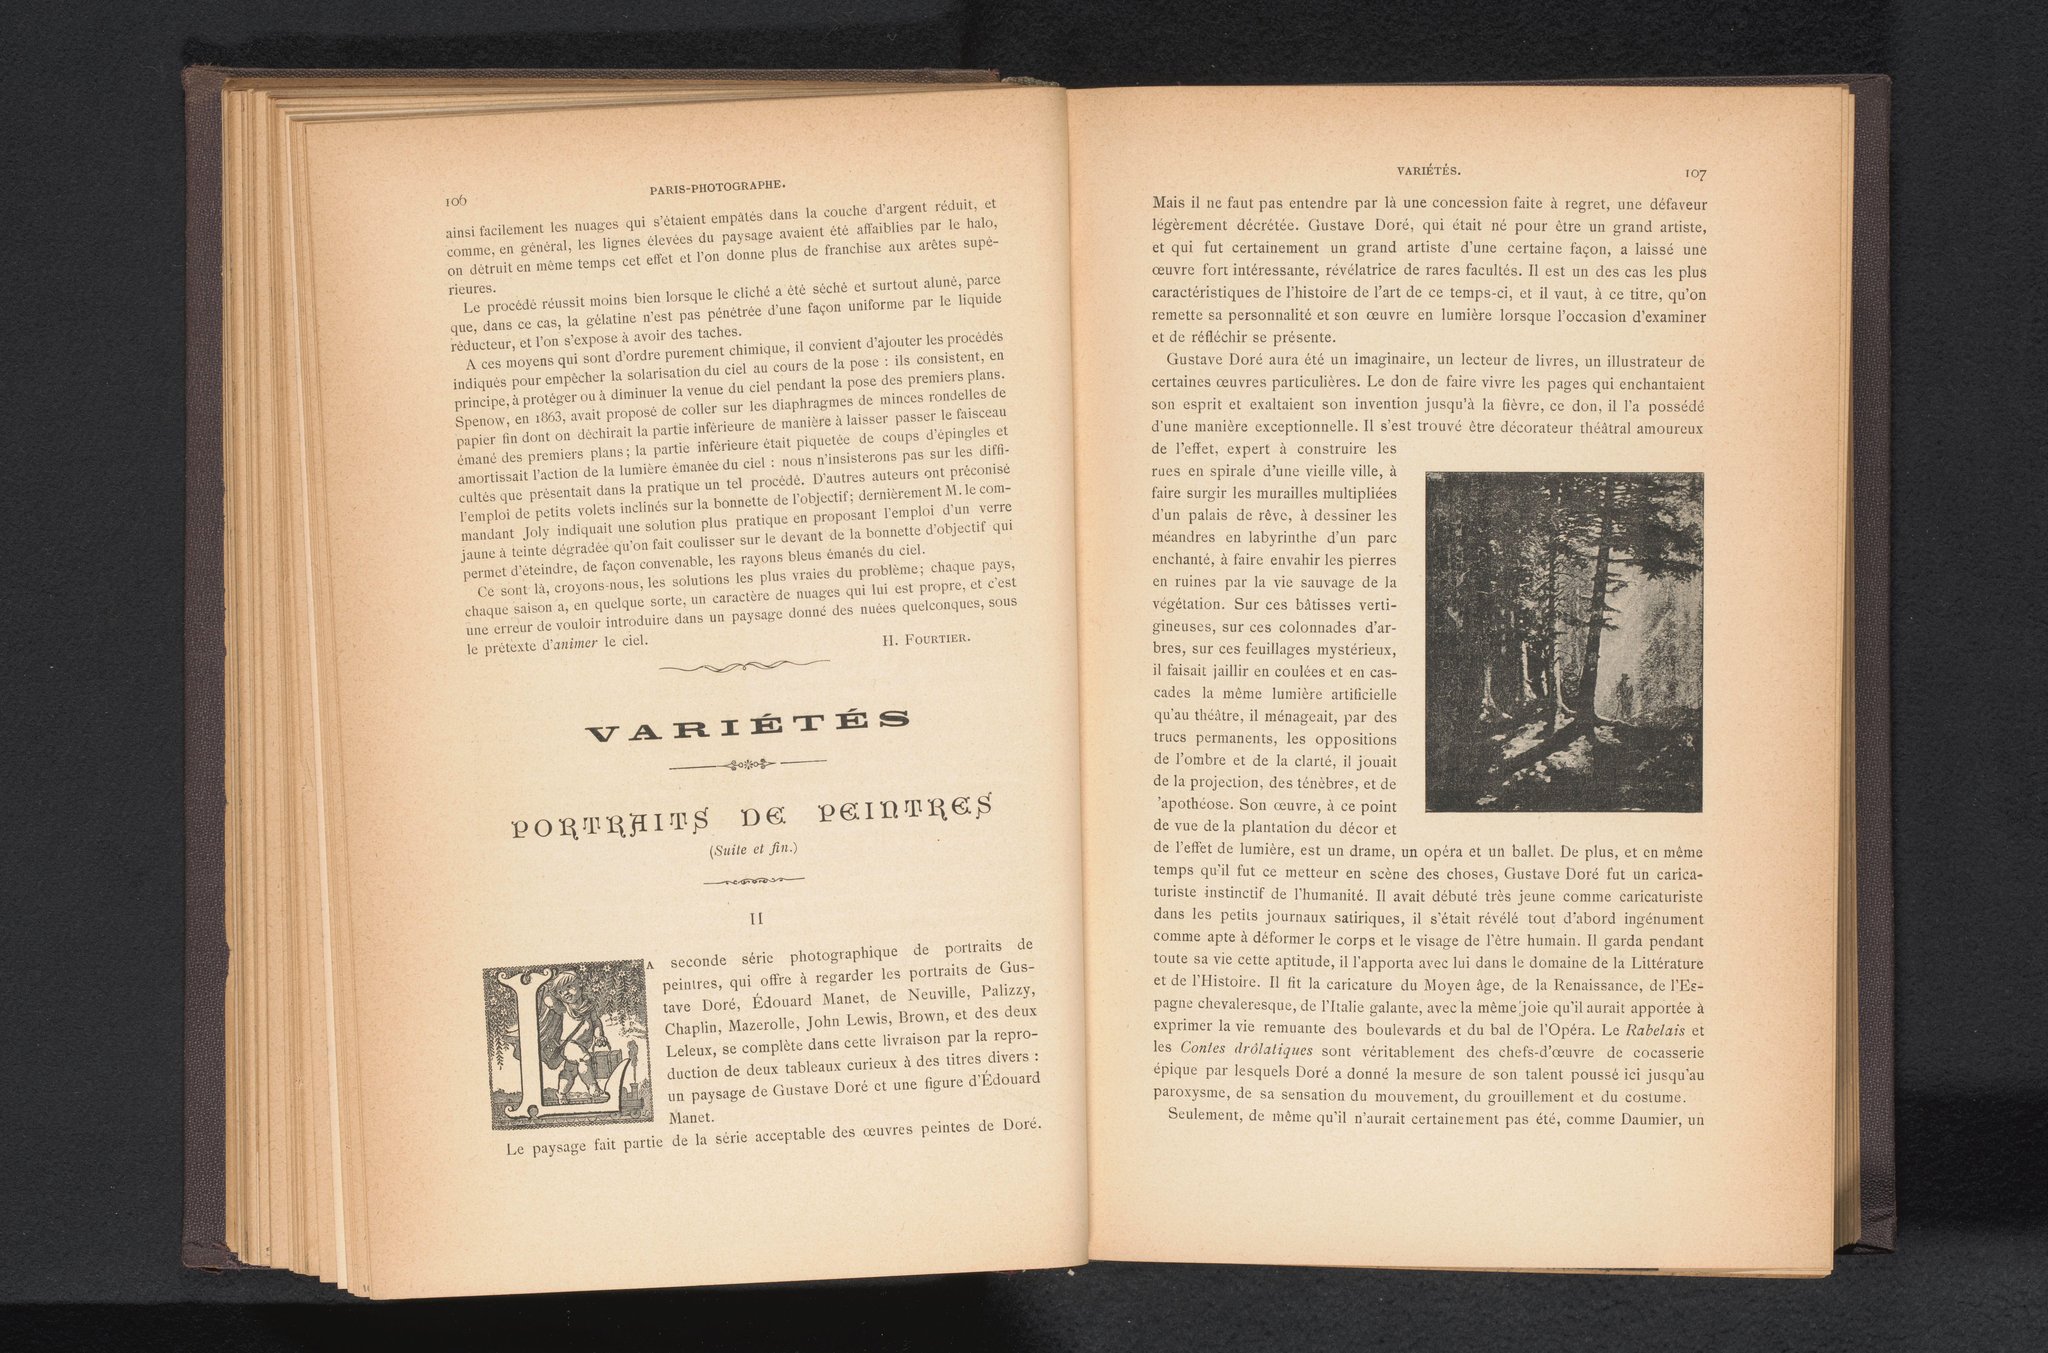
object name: page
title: Fotoreproductie van een afbeelding van een bos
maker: Anonymous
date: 1883-1893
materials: paper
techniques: autotype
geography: france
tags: forest, wood